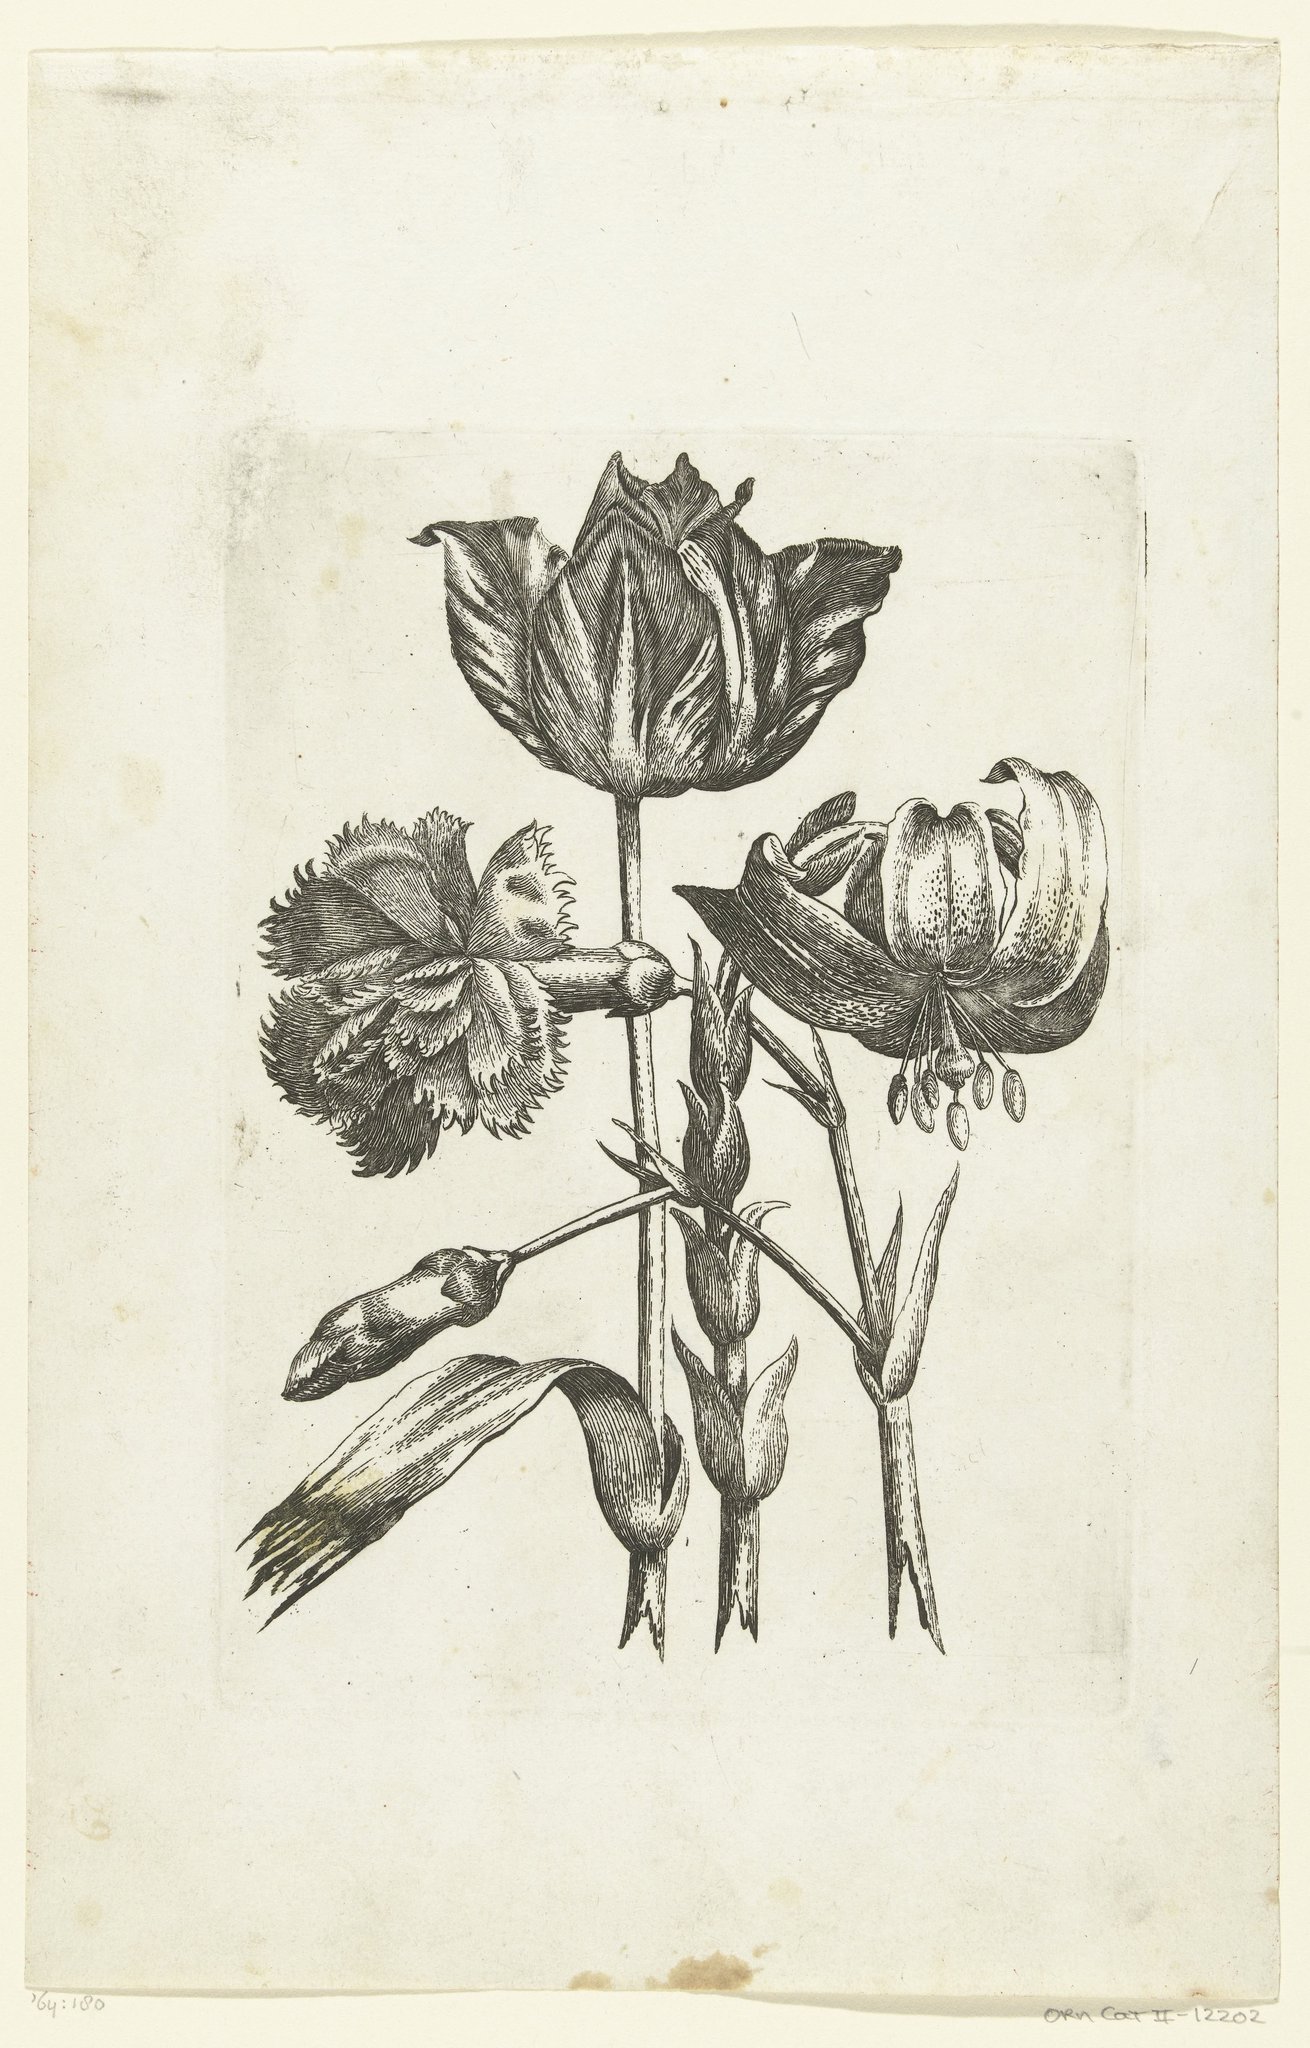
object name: print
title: Anjer, tulp en lelie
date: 1667-1701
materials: paper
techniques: etching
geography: amsterdam